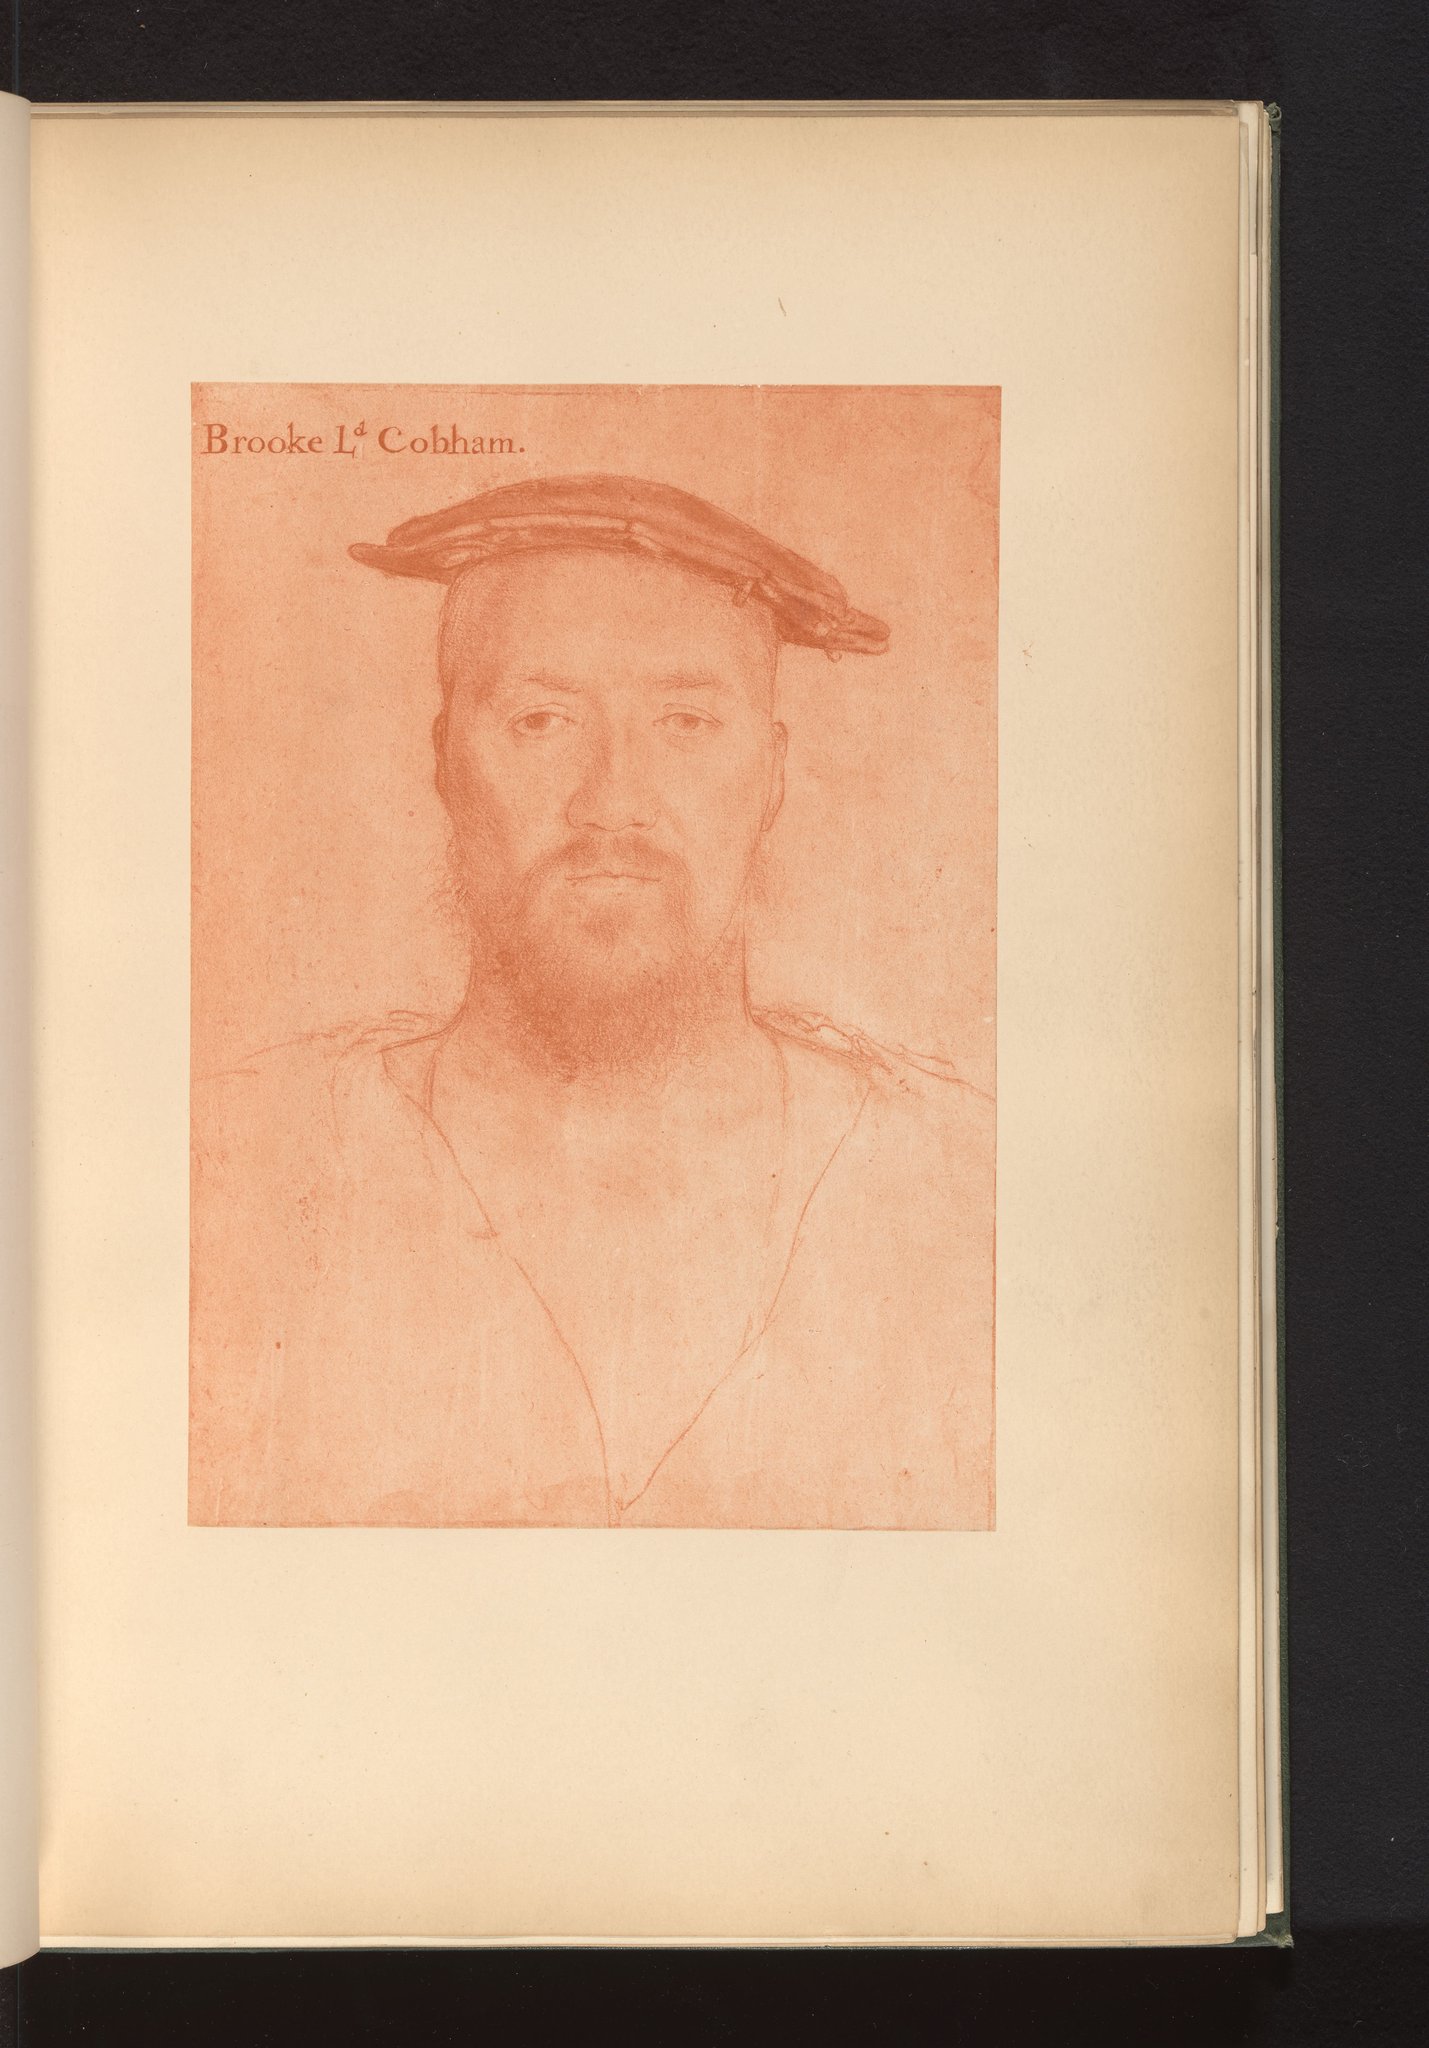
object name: reproduction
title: Fotoreproductie van een portret van George Brooke, baron van Cobham, door Hans Holbein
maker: Anonymous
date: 1872-1877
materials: paper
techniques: carbon print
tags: drawing, sketch, historical persons